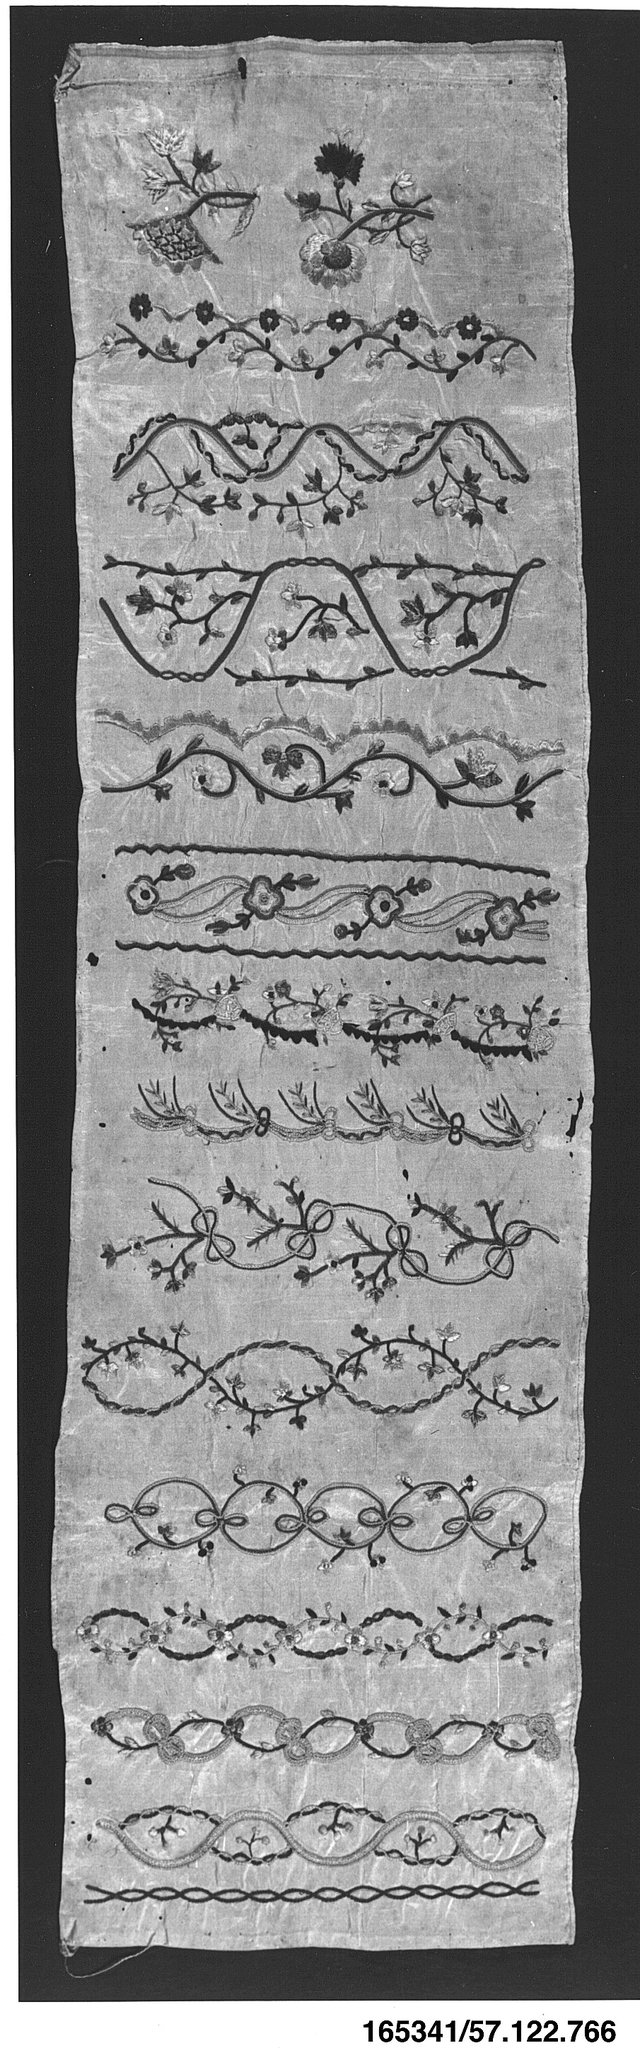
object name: sampler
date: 1801-1900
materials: silk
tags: flowers